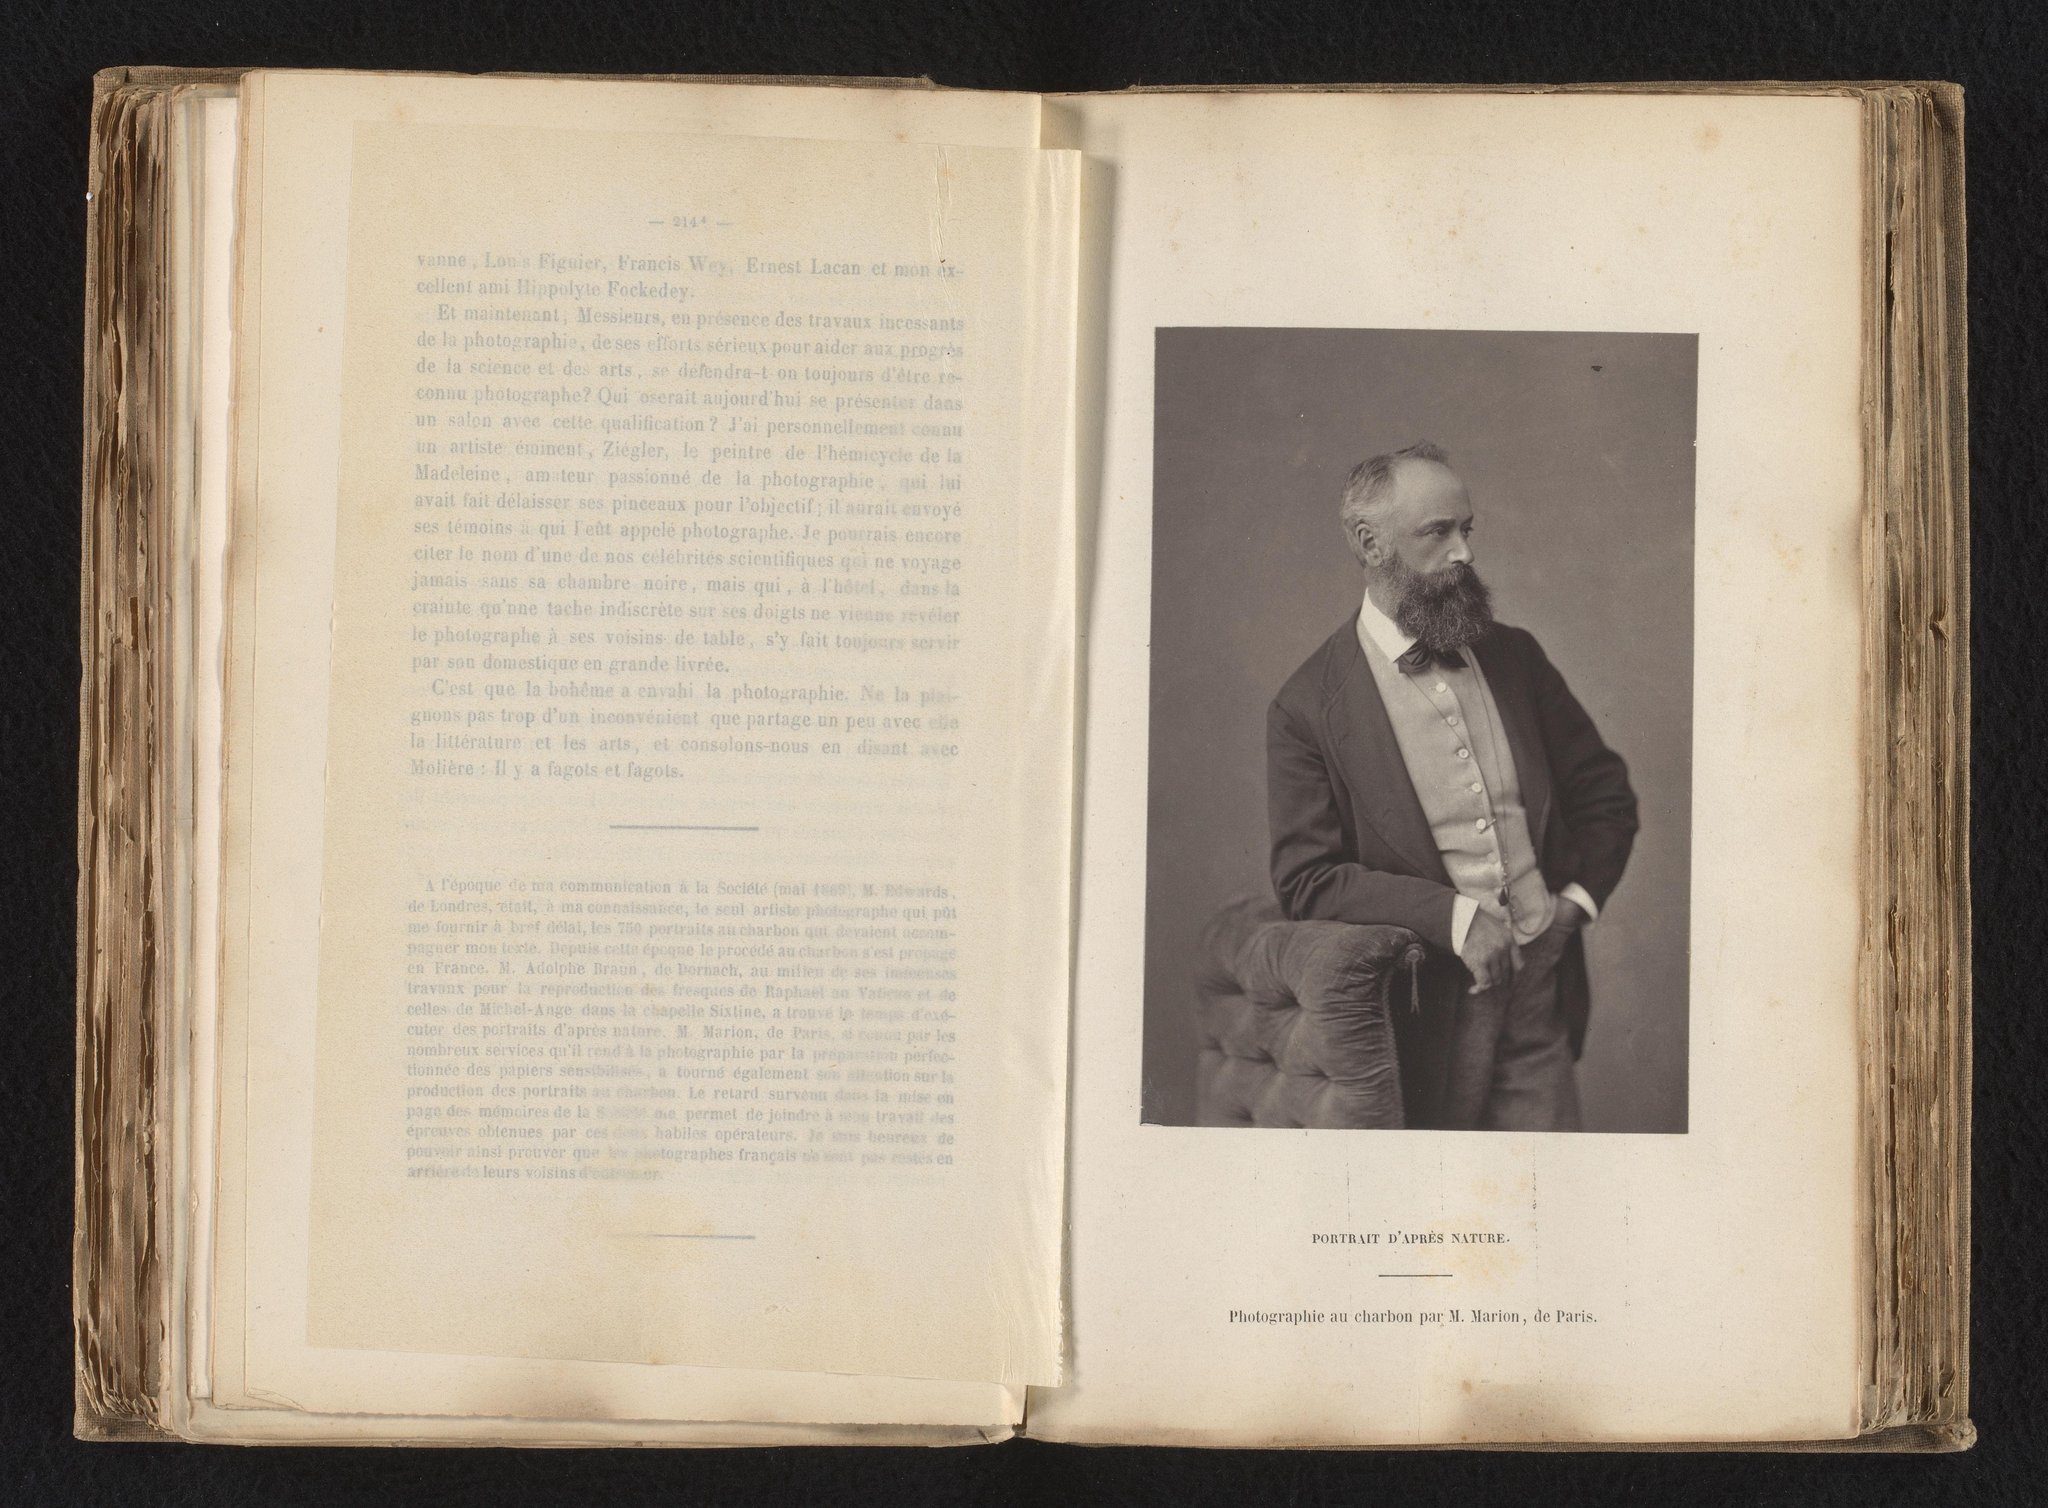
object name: page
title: Portret van een onbekende man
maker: m. marion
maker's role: fotograaf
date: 1865-1870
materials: paper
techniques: carbon print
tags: anonymous historical person portrayed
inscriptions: inscription: ‘PORTRAIT D'APRÈS NATURE./ PHotographie au charbon par M. Marion, de Paris.’